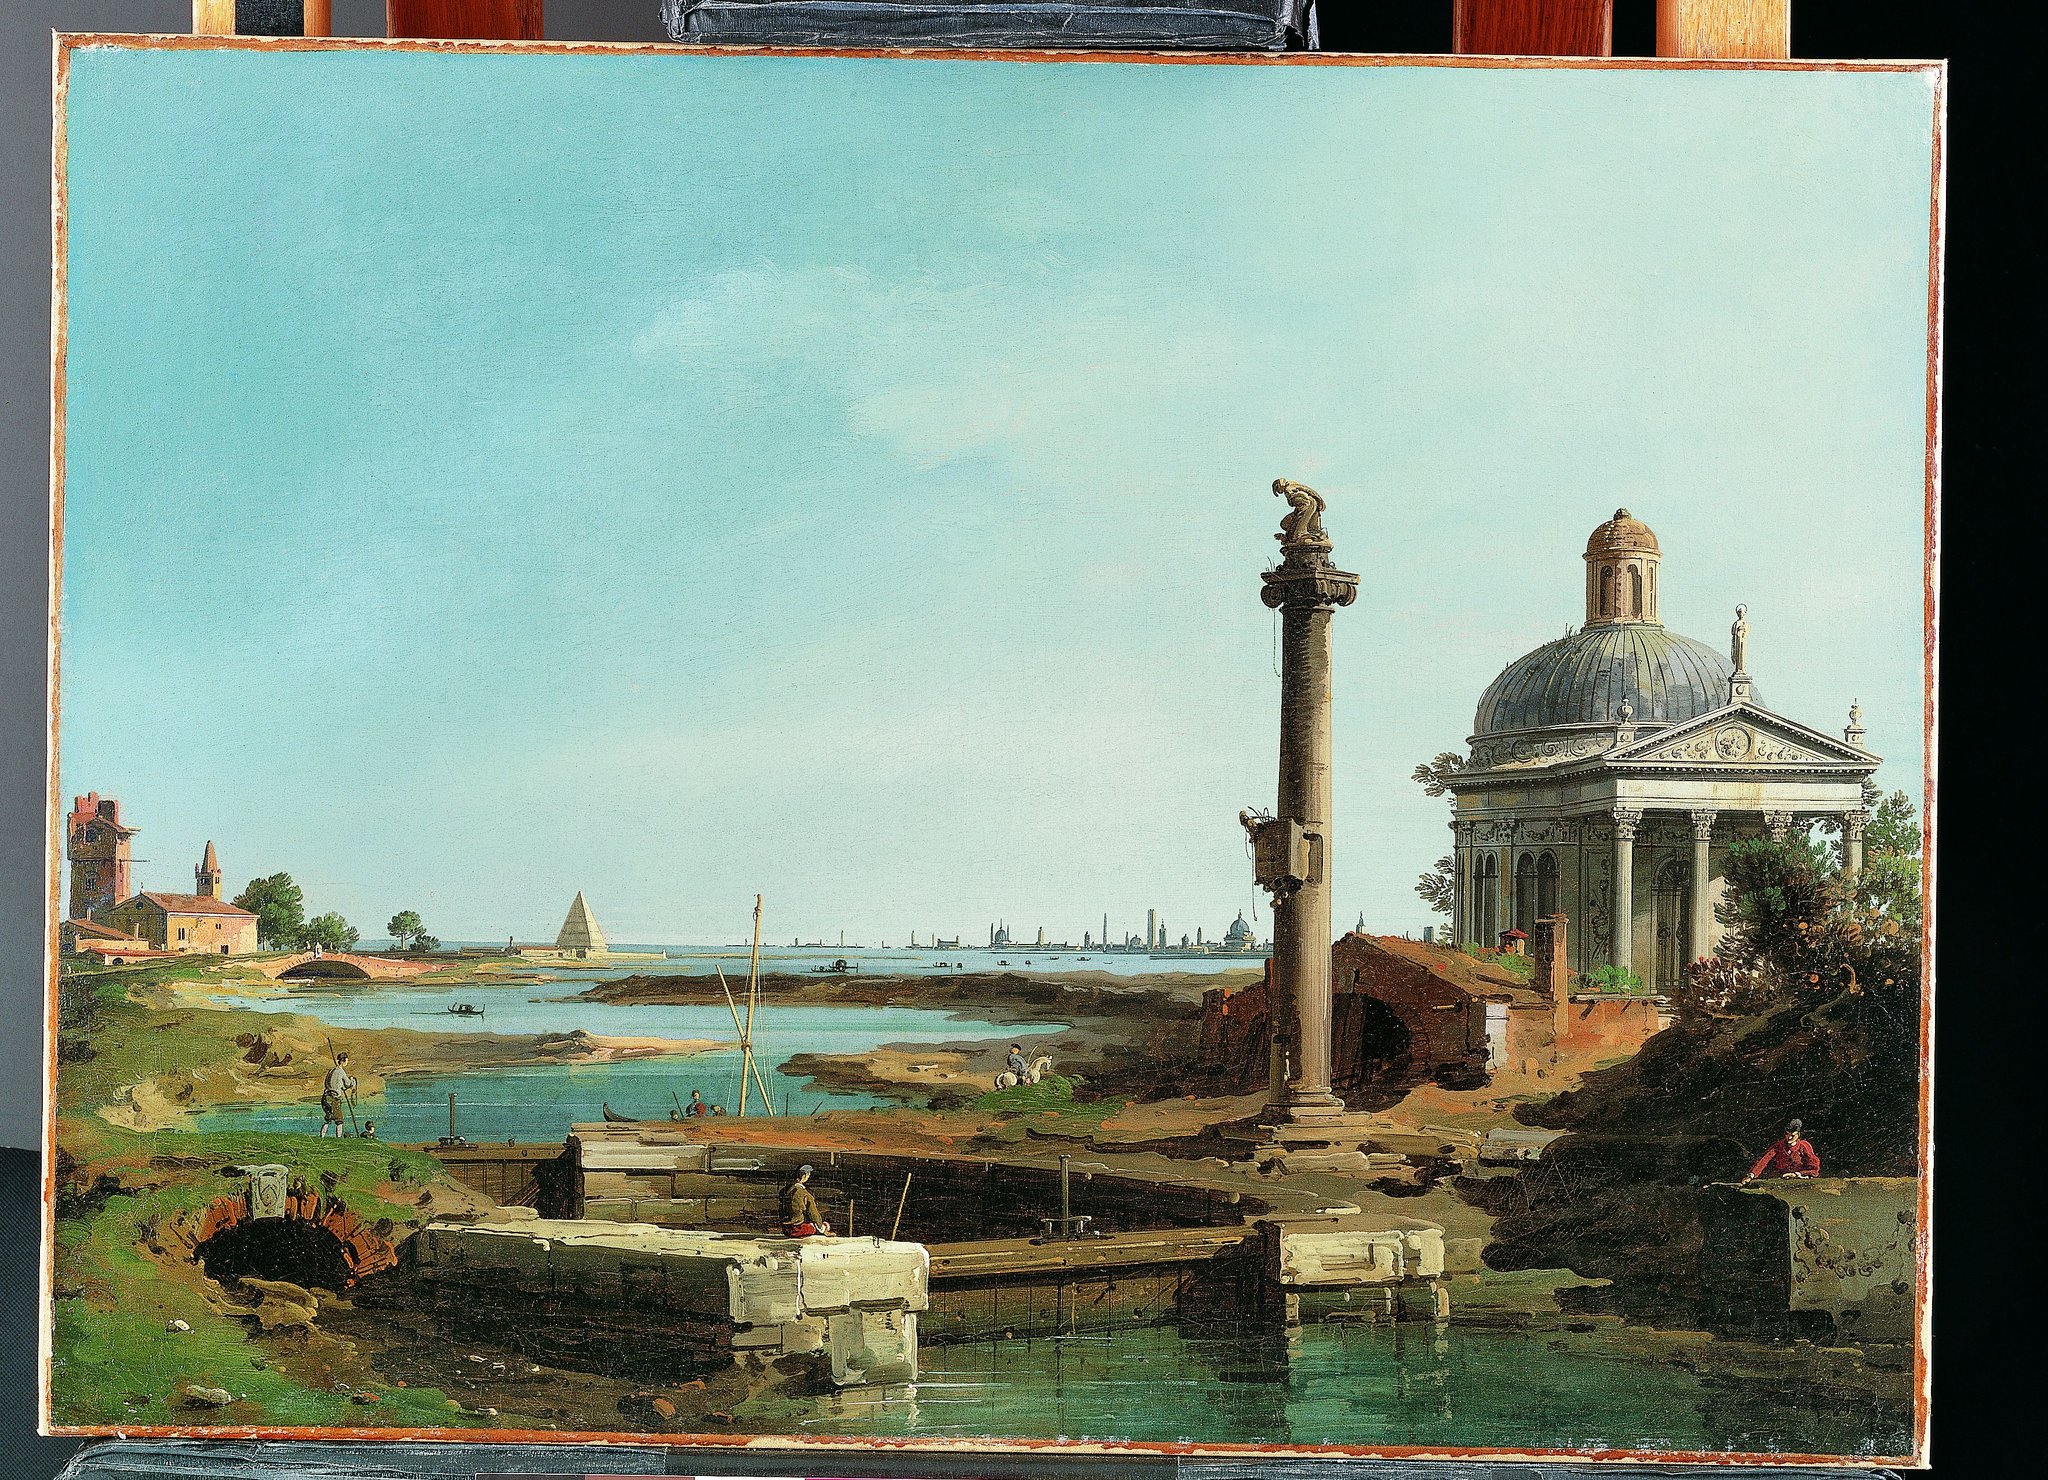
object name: painting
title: A Lock, a Column, and a Church beside a Lagoon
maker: canaletto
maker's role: artist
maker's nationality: italian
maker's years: 1697-1768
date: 1717-1768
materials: canvas, oil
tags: columns,churches,venice